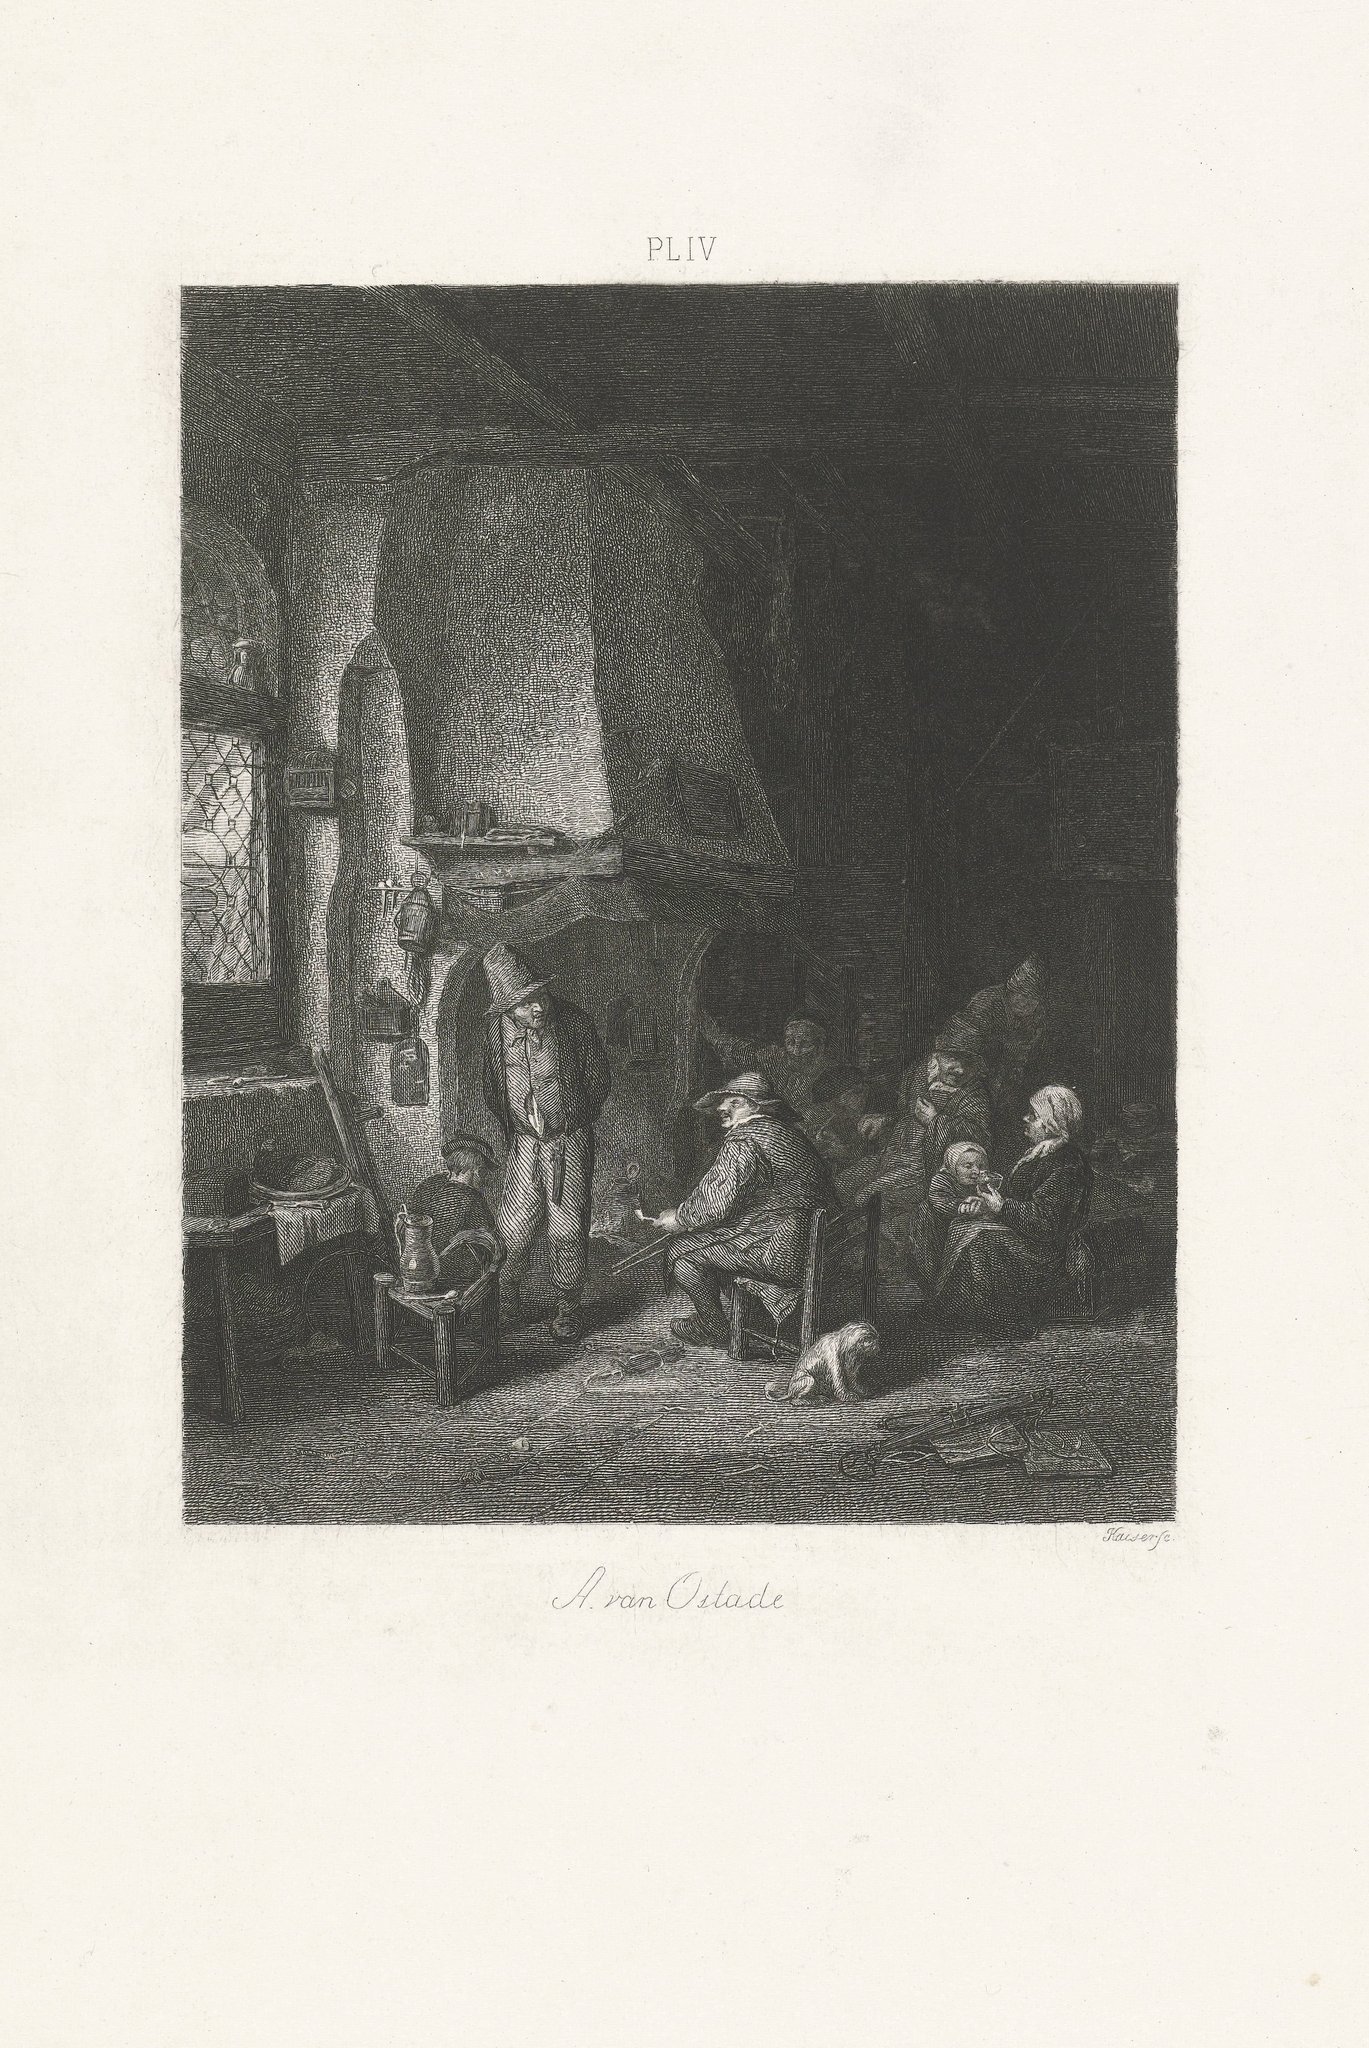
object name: print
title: Hollandse meesters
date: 1823-1900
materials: paper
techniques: etching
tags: farmers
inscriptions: collector's mark: Lugt 2228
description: Een boereninterieur waarin zes figuren en een hond bij een haard zitten en drie figuren, waaronder een kind, bij de haard staan. De prent maakt deel uit van een serie van 25 prenten naar Hollandse meesters. Boven de afbeelding: PL IV.